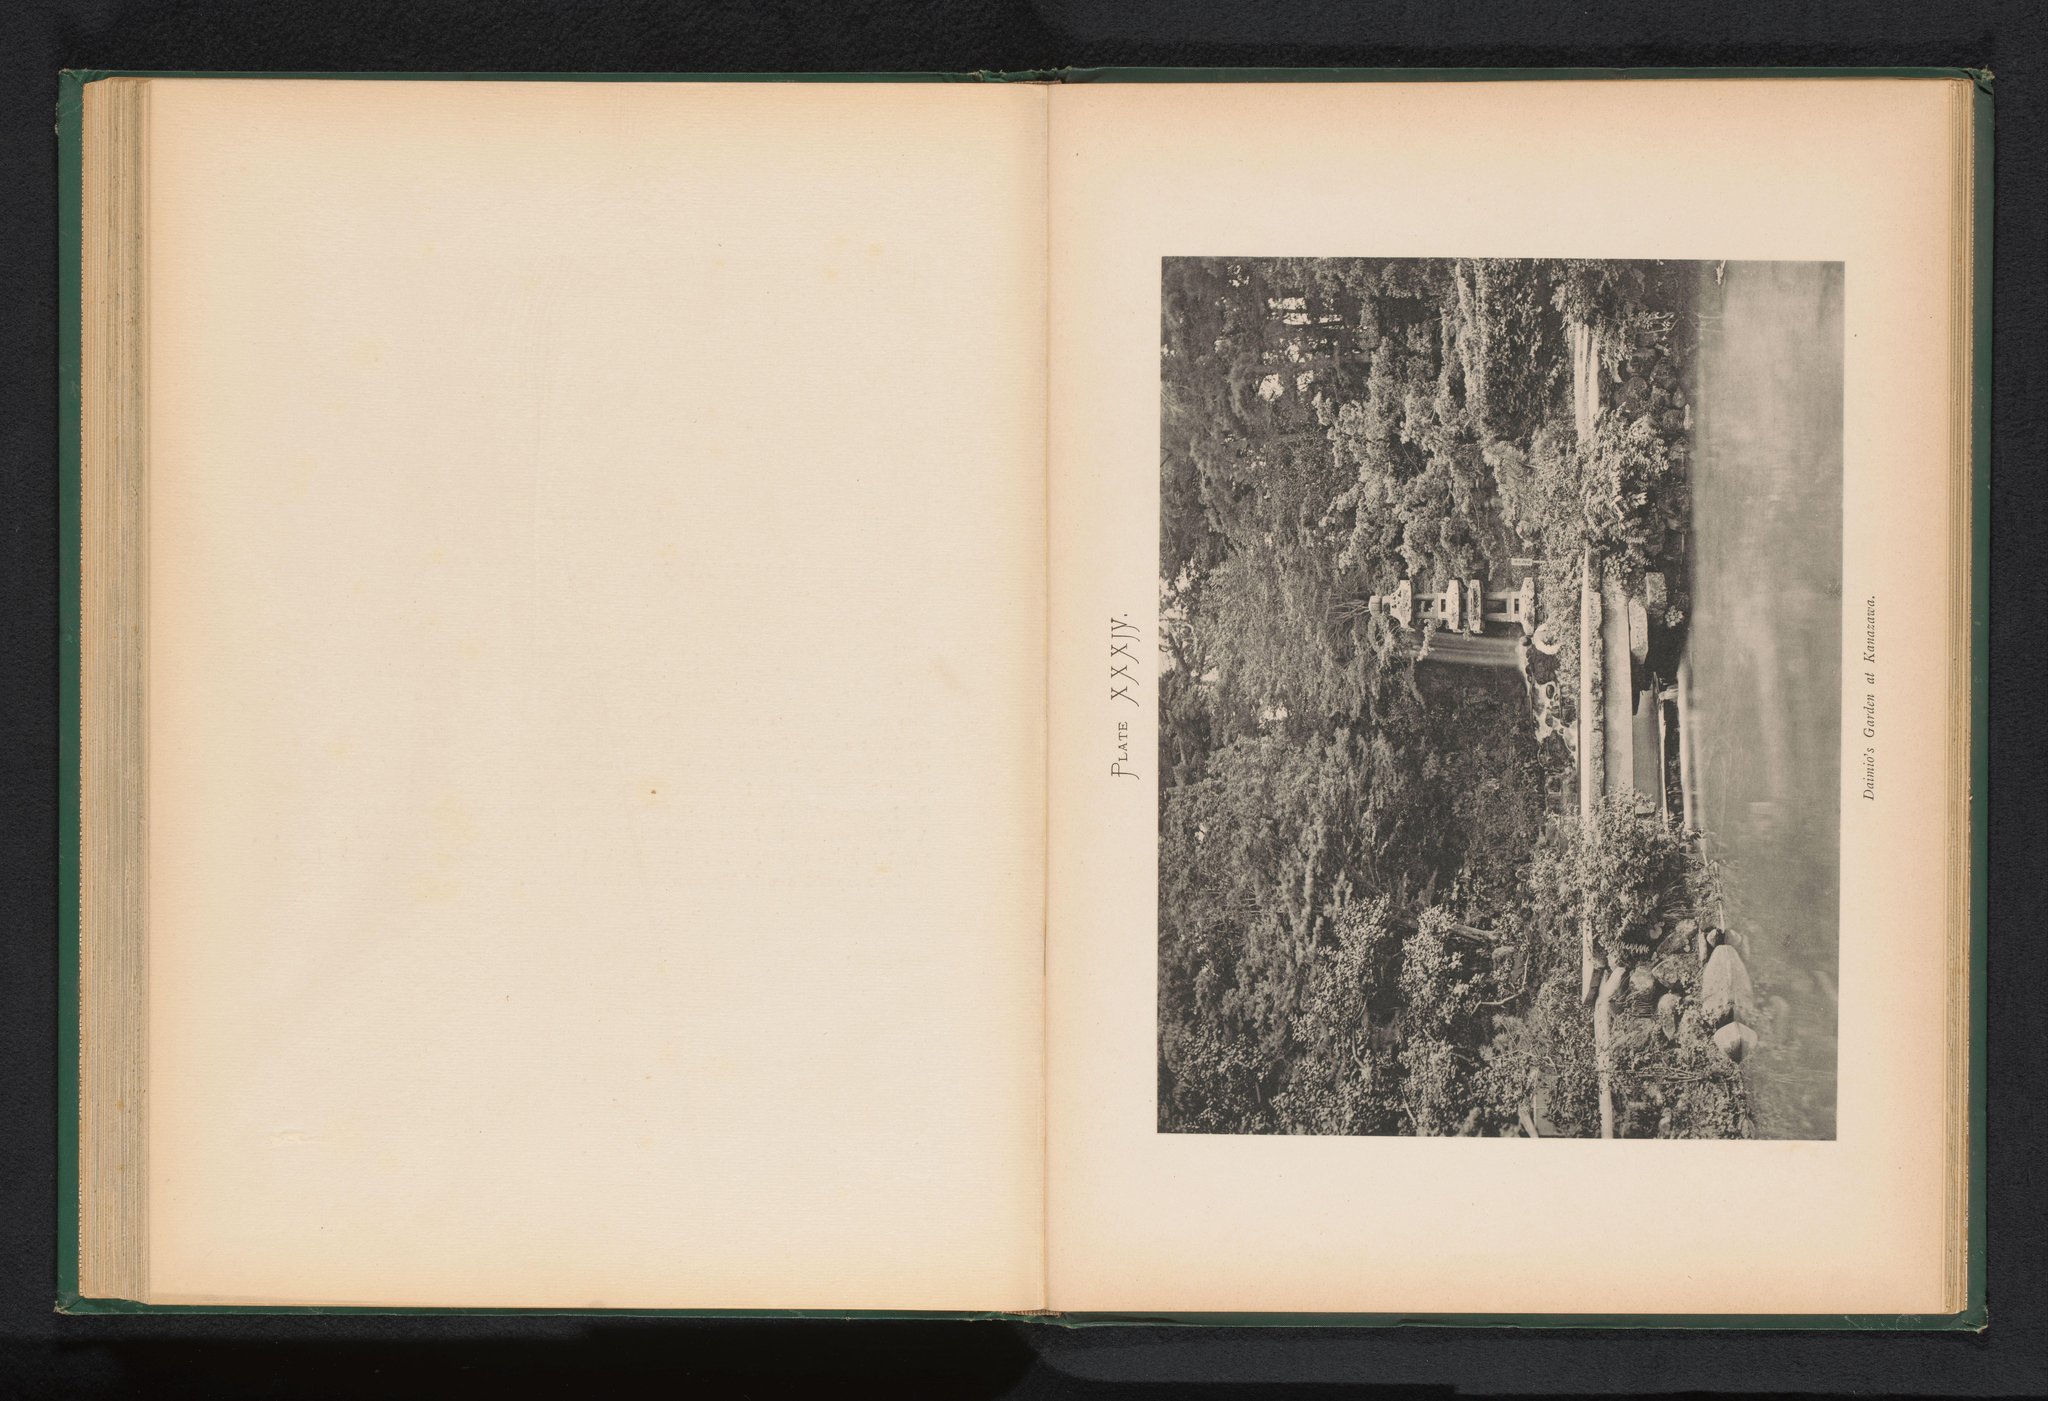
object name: photomechanical print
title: Gezicht op de tuinen van een Daimio in Kanazawa, Japan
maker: kazumasa ogawa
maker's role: auteur, fotograaf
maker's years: 1860-1929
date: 1888-1893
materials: paper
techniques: photograph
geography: kanazawa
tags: garden, pond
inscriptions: inscription: ‘Plate XXXIV.’